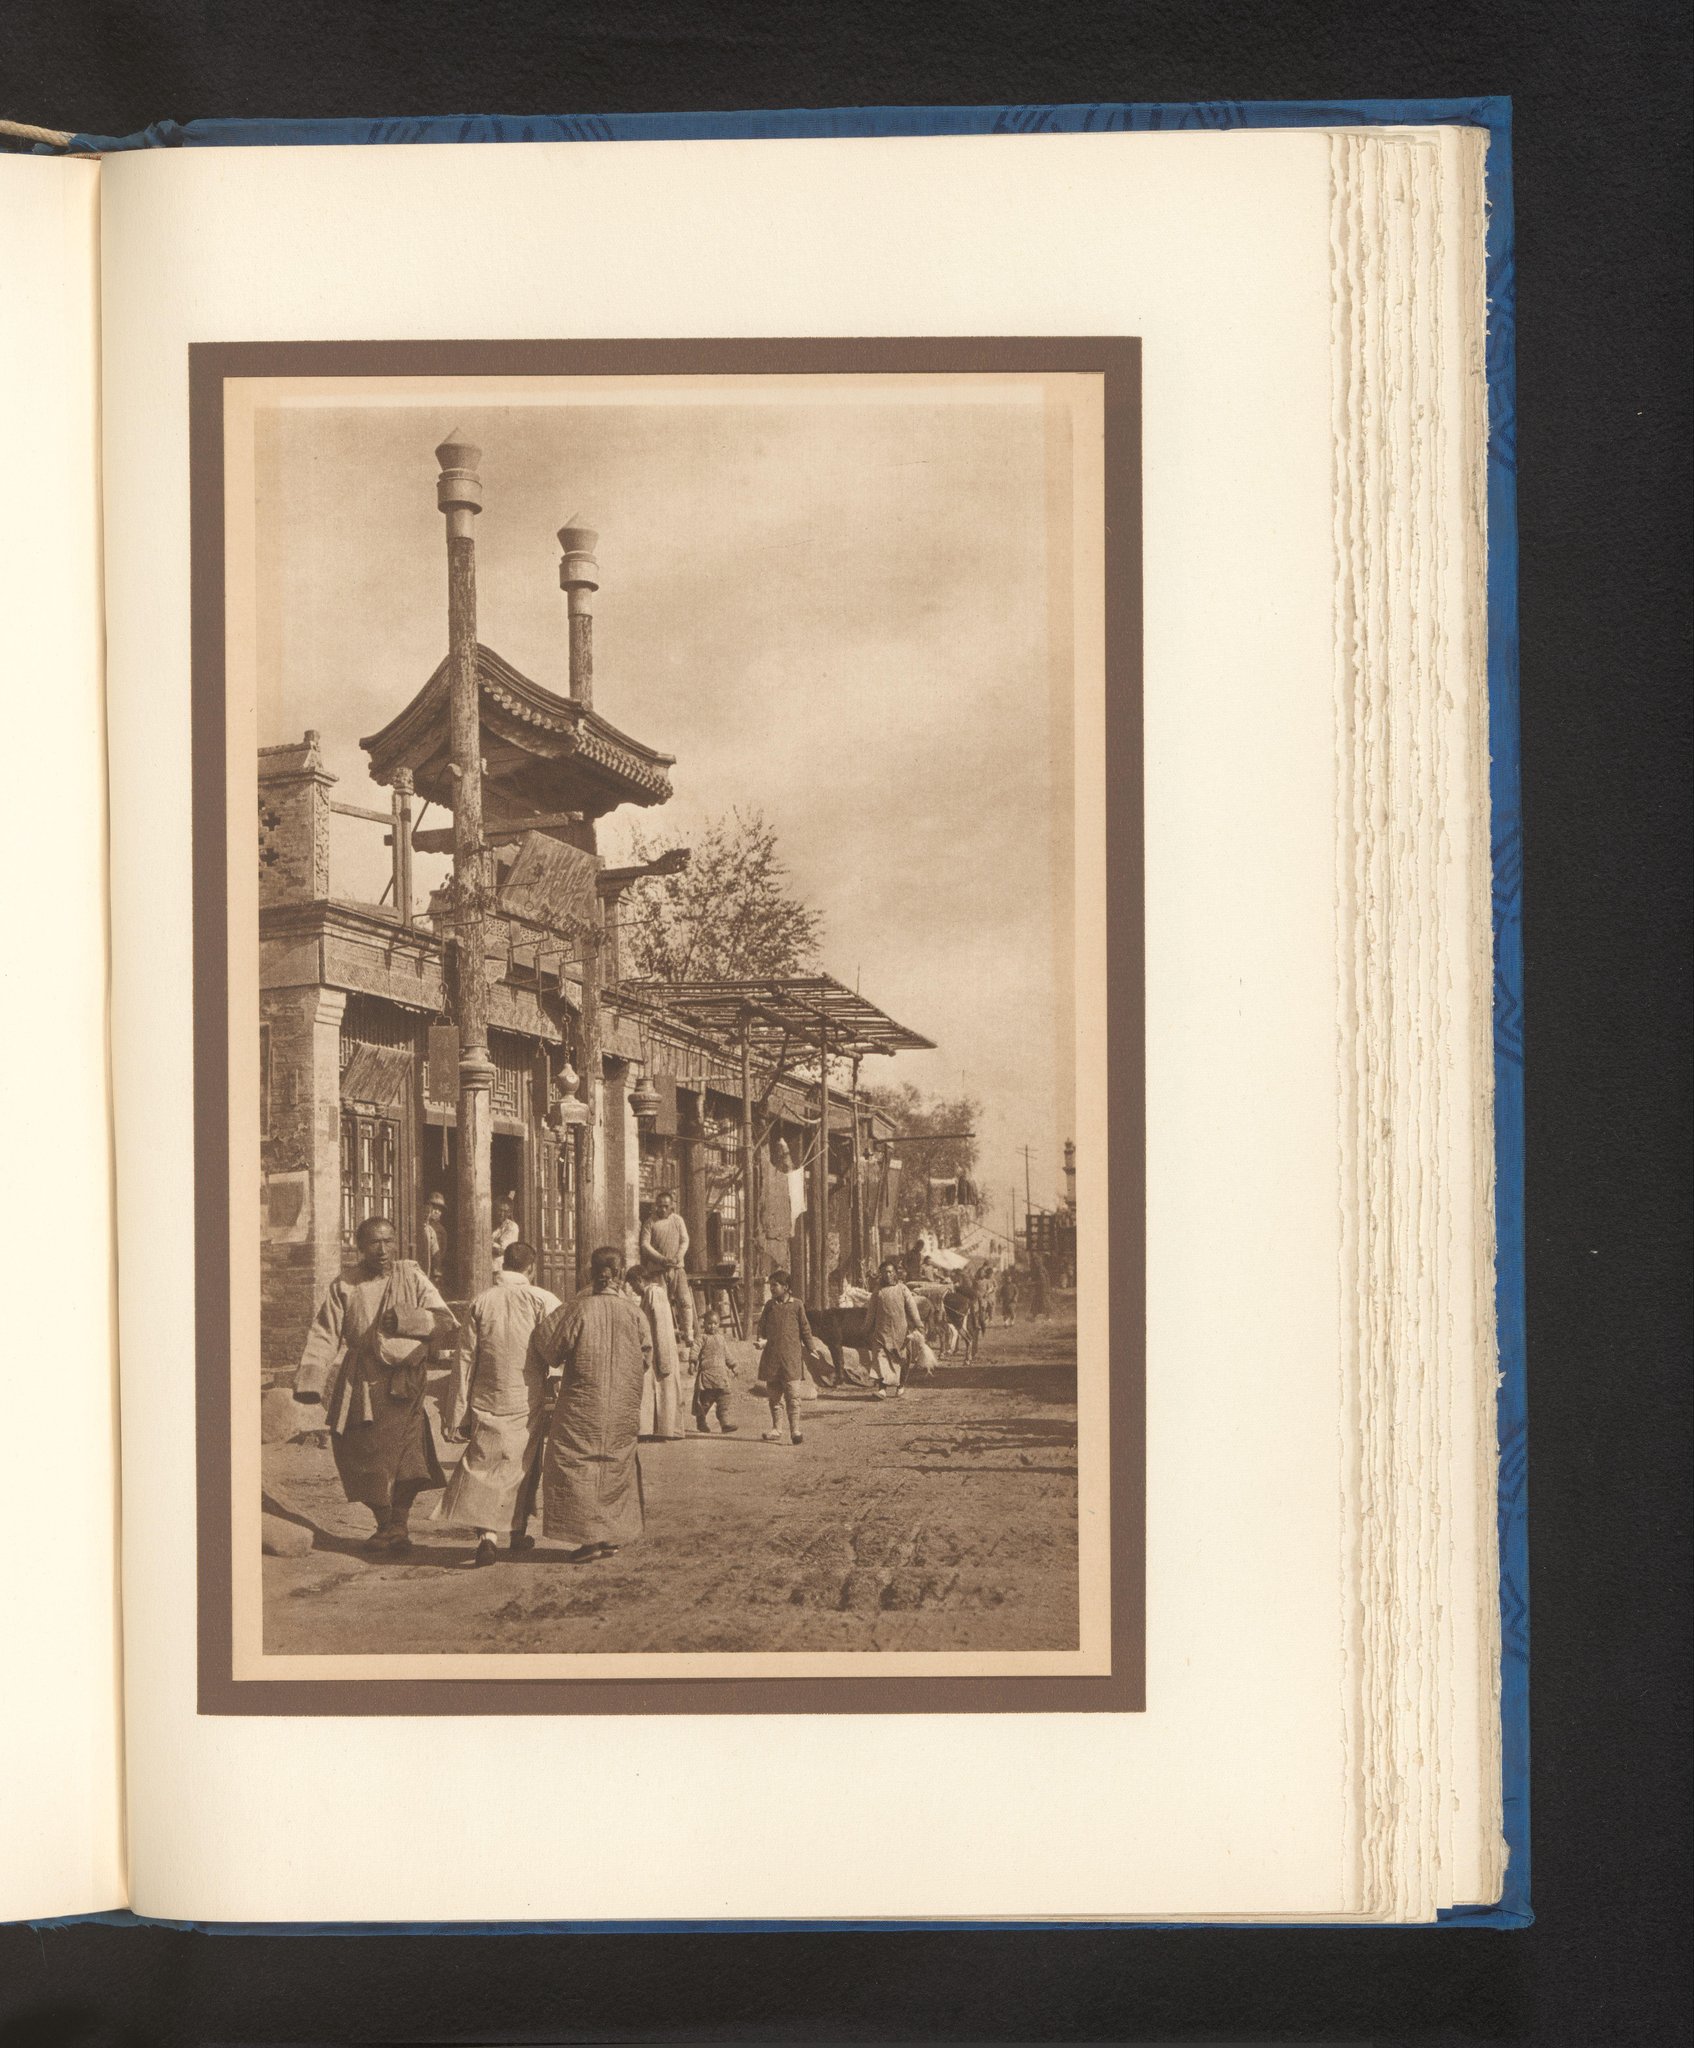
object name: photomechanical print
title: Straatgezicht te Peking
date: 1915-1920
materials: paper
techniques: rotogravure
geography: beijing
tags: street